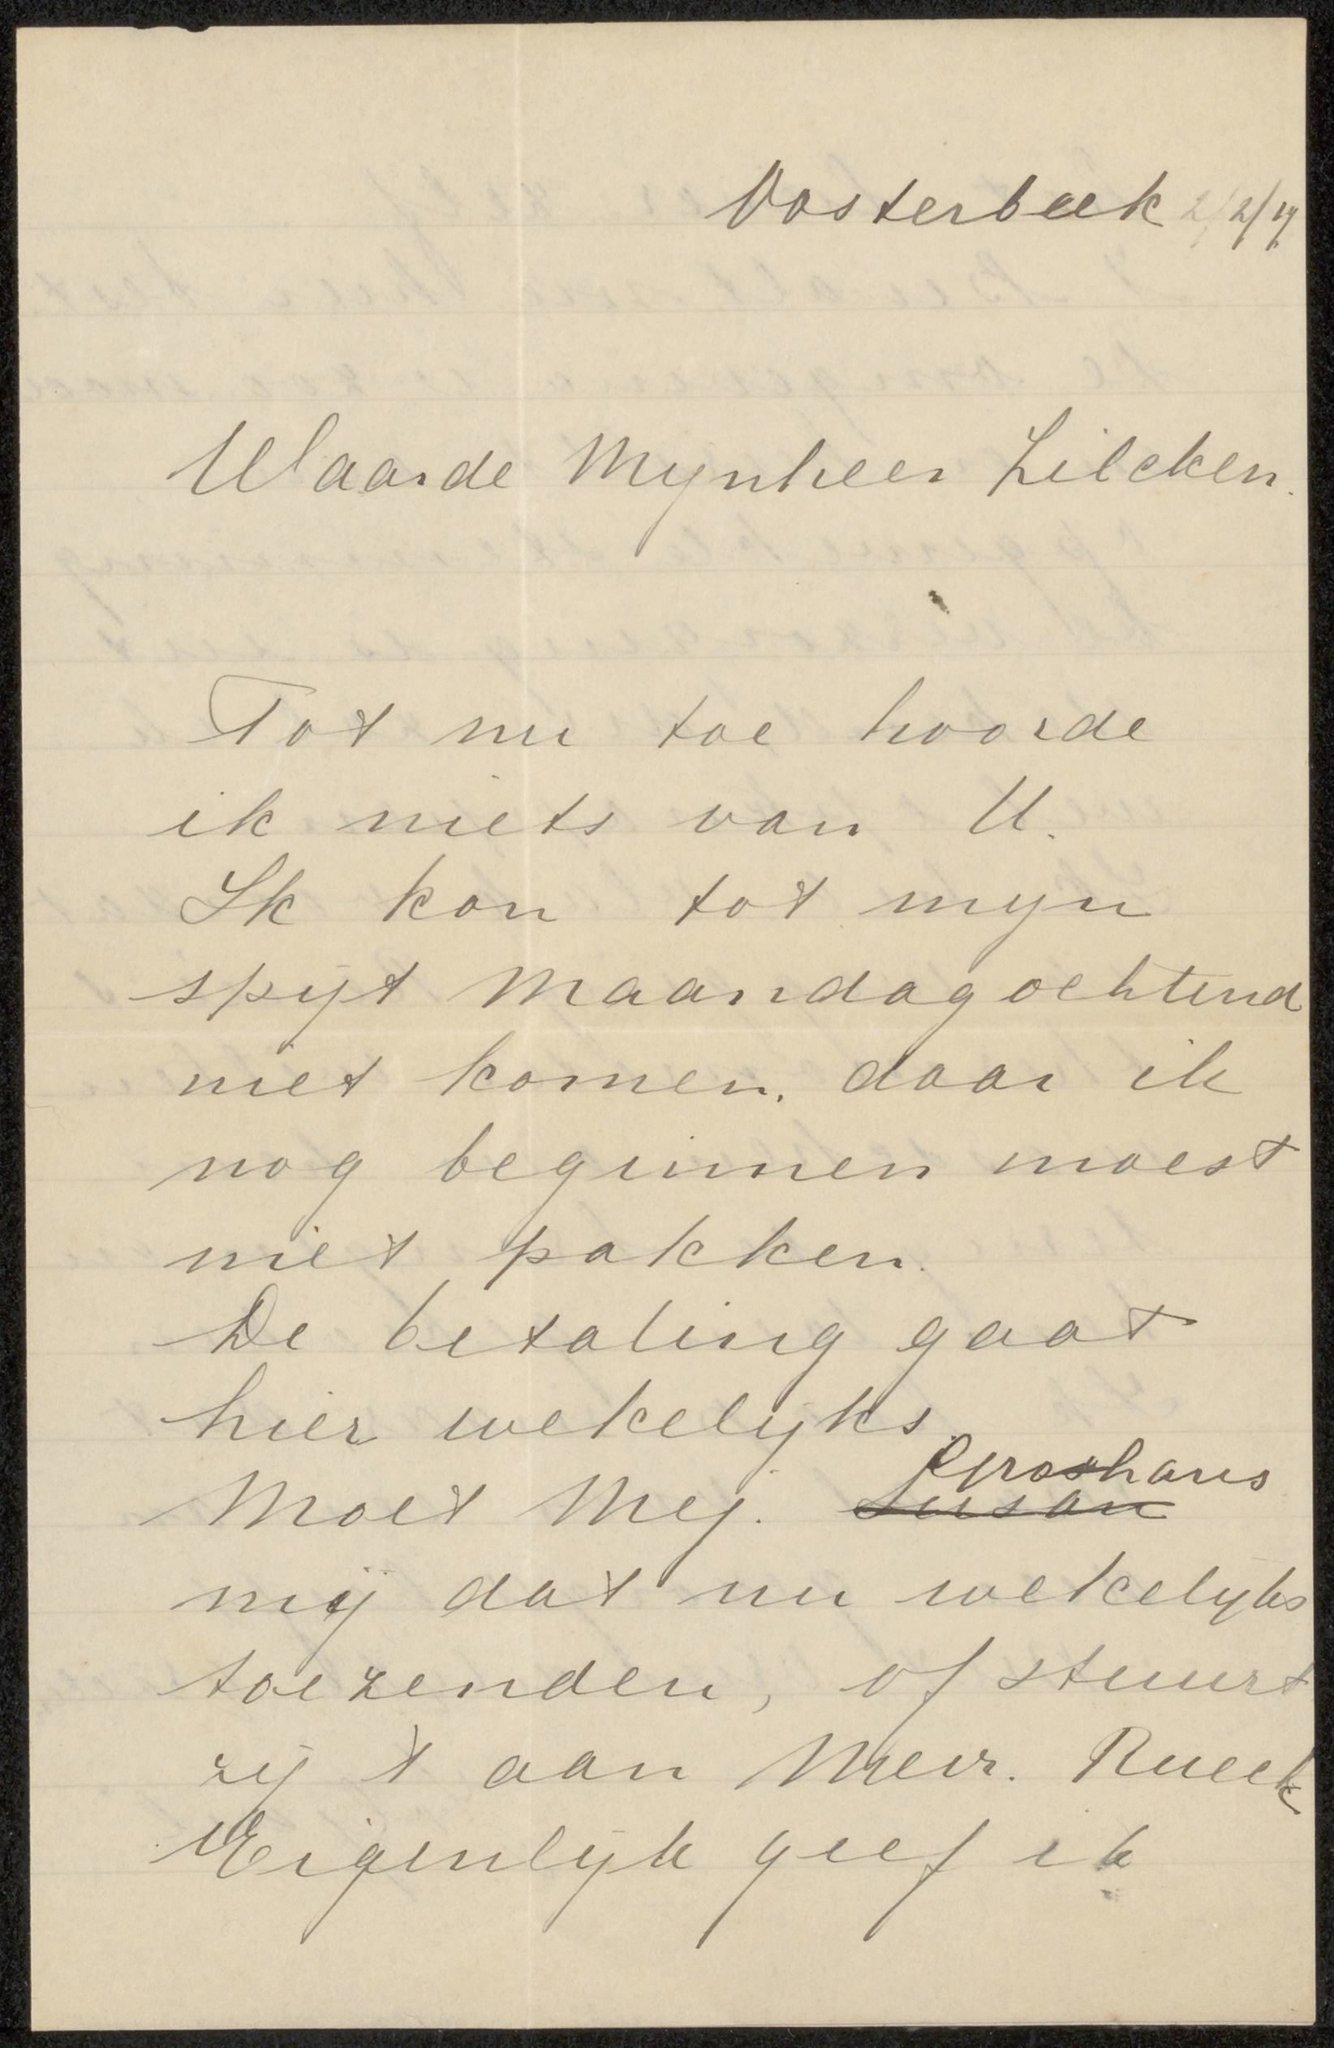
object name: letter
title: Brief aan Philip Zilcken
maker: jo geul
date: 1917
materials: ink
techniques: pen, writing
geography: oosterbeek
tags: painter, draughtsman, philip zilcken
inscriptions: collector's mark: ‘RPK’